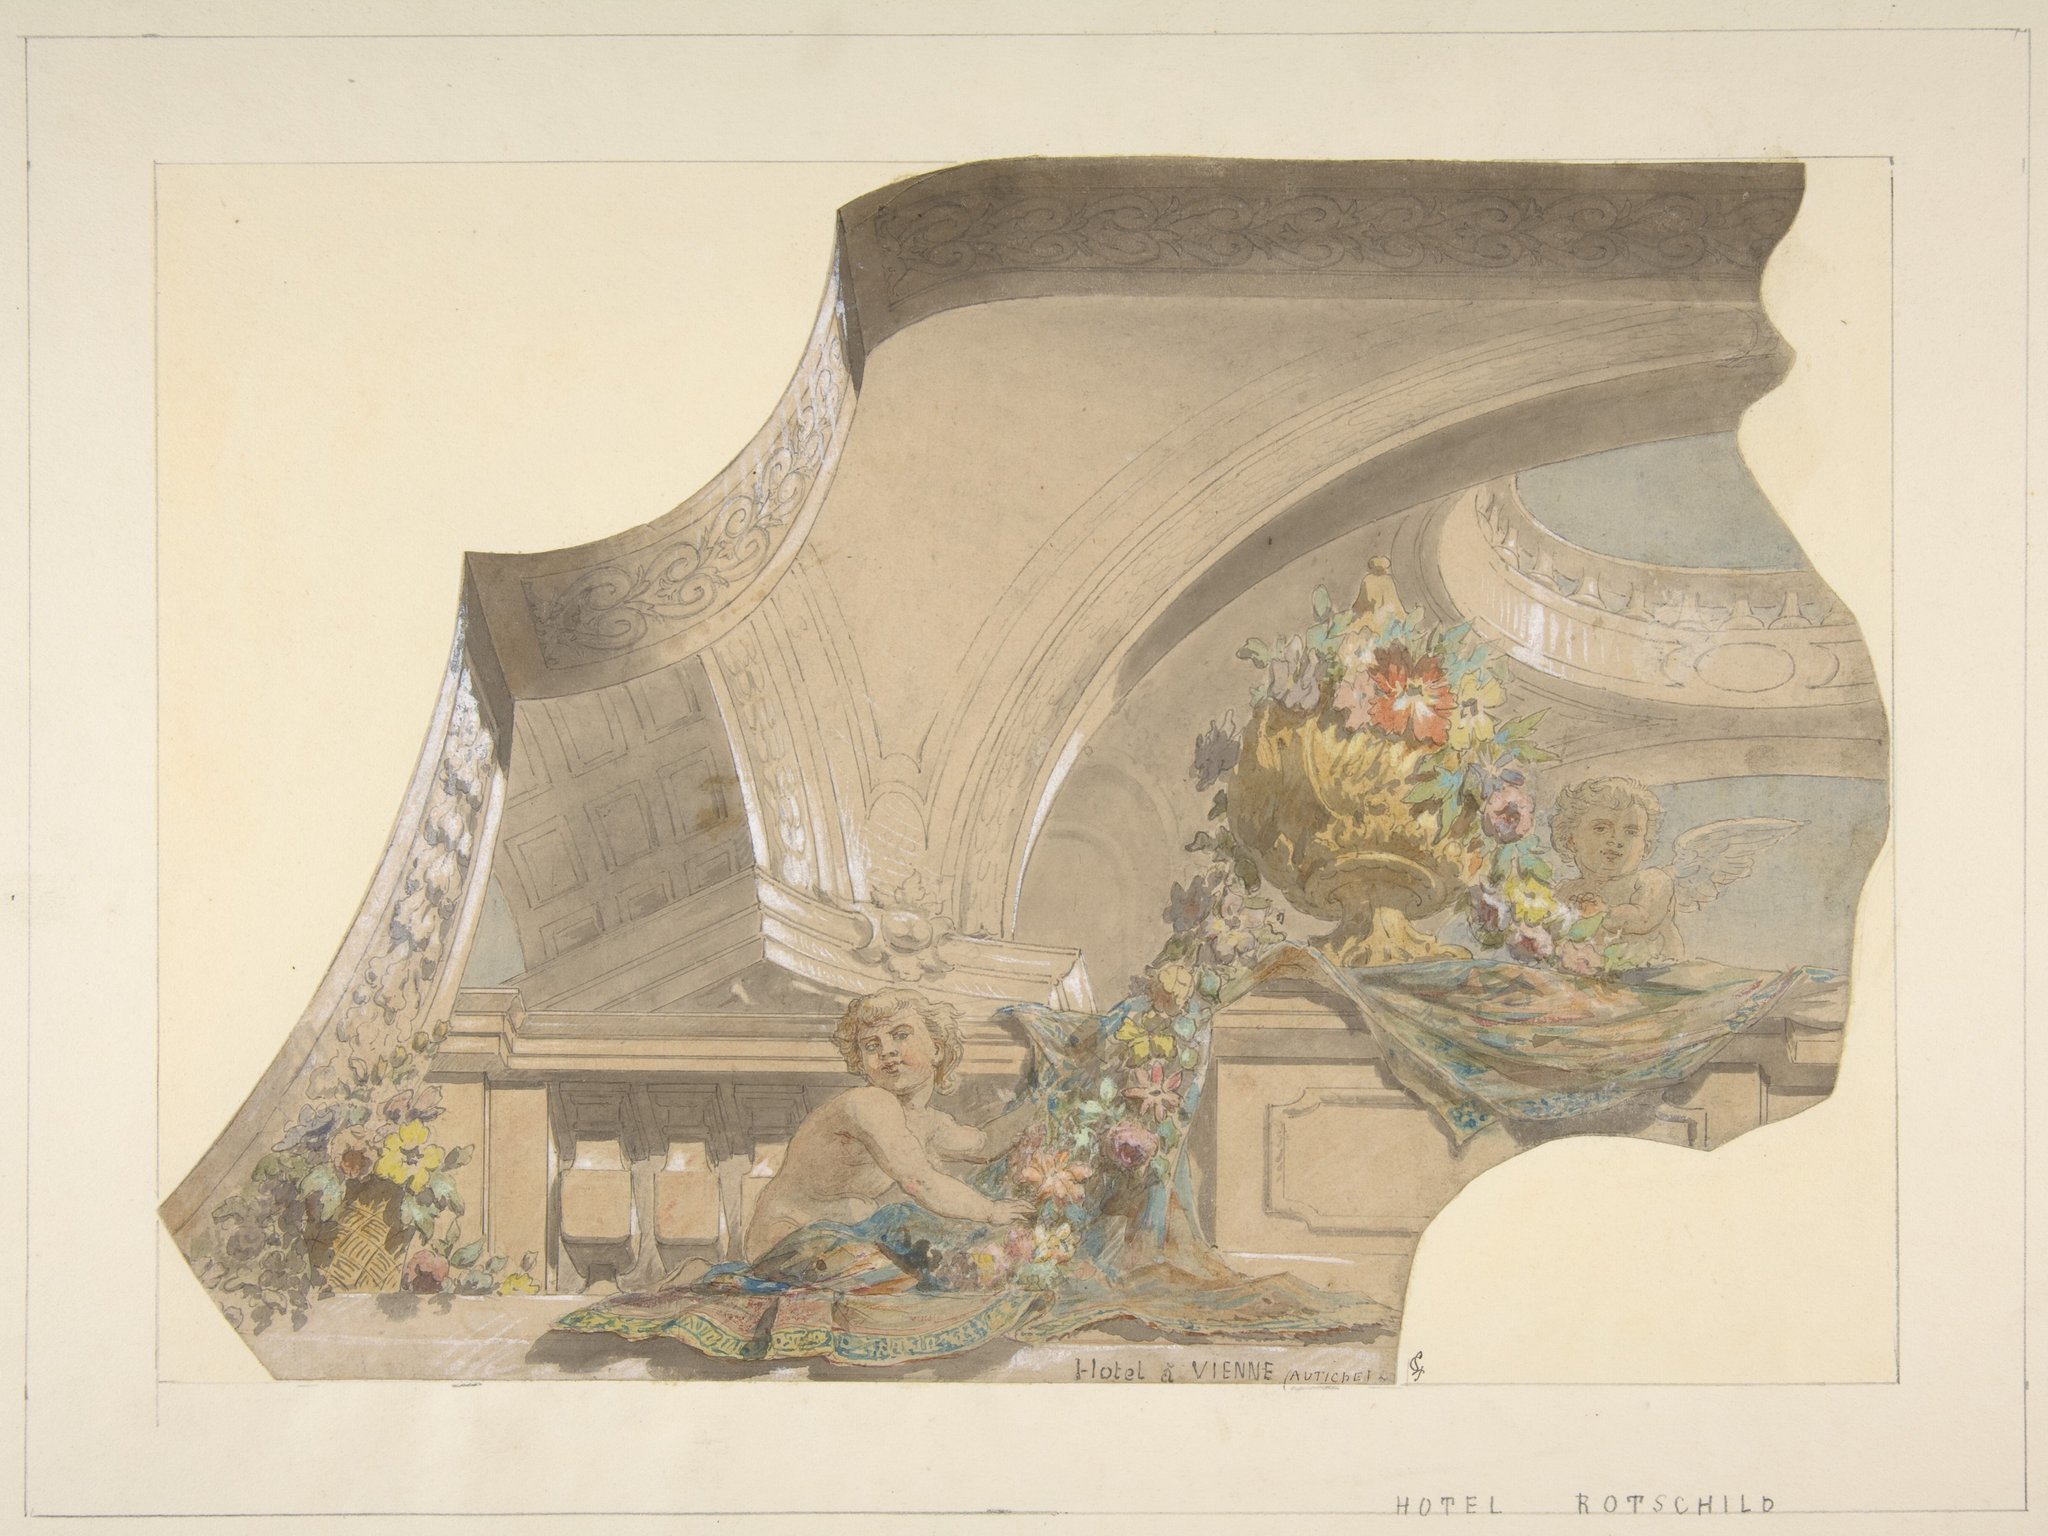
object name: drawing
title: Ceiling and Cove Designs for Stairway, Hôtel Rothschild, Vienna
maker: jules-edmond-charles lachaise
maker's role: artist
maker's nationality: french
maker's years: 1897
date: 1851-1900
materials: ink, watercolor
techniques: pen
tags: boys,flowers